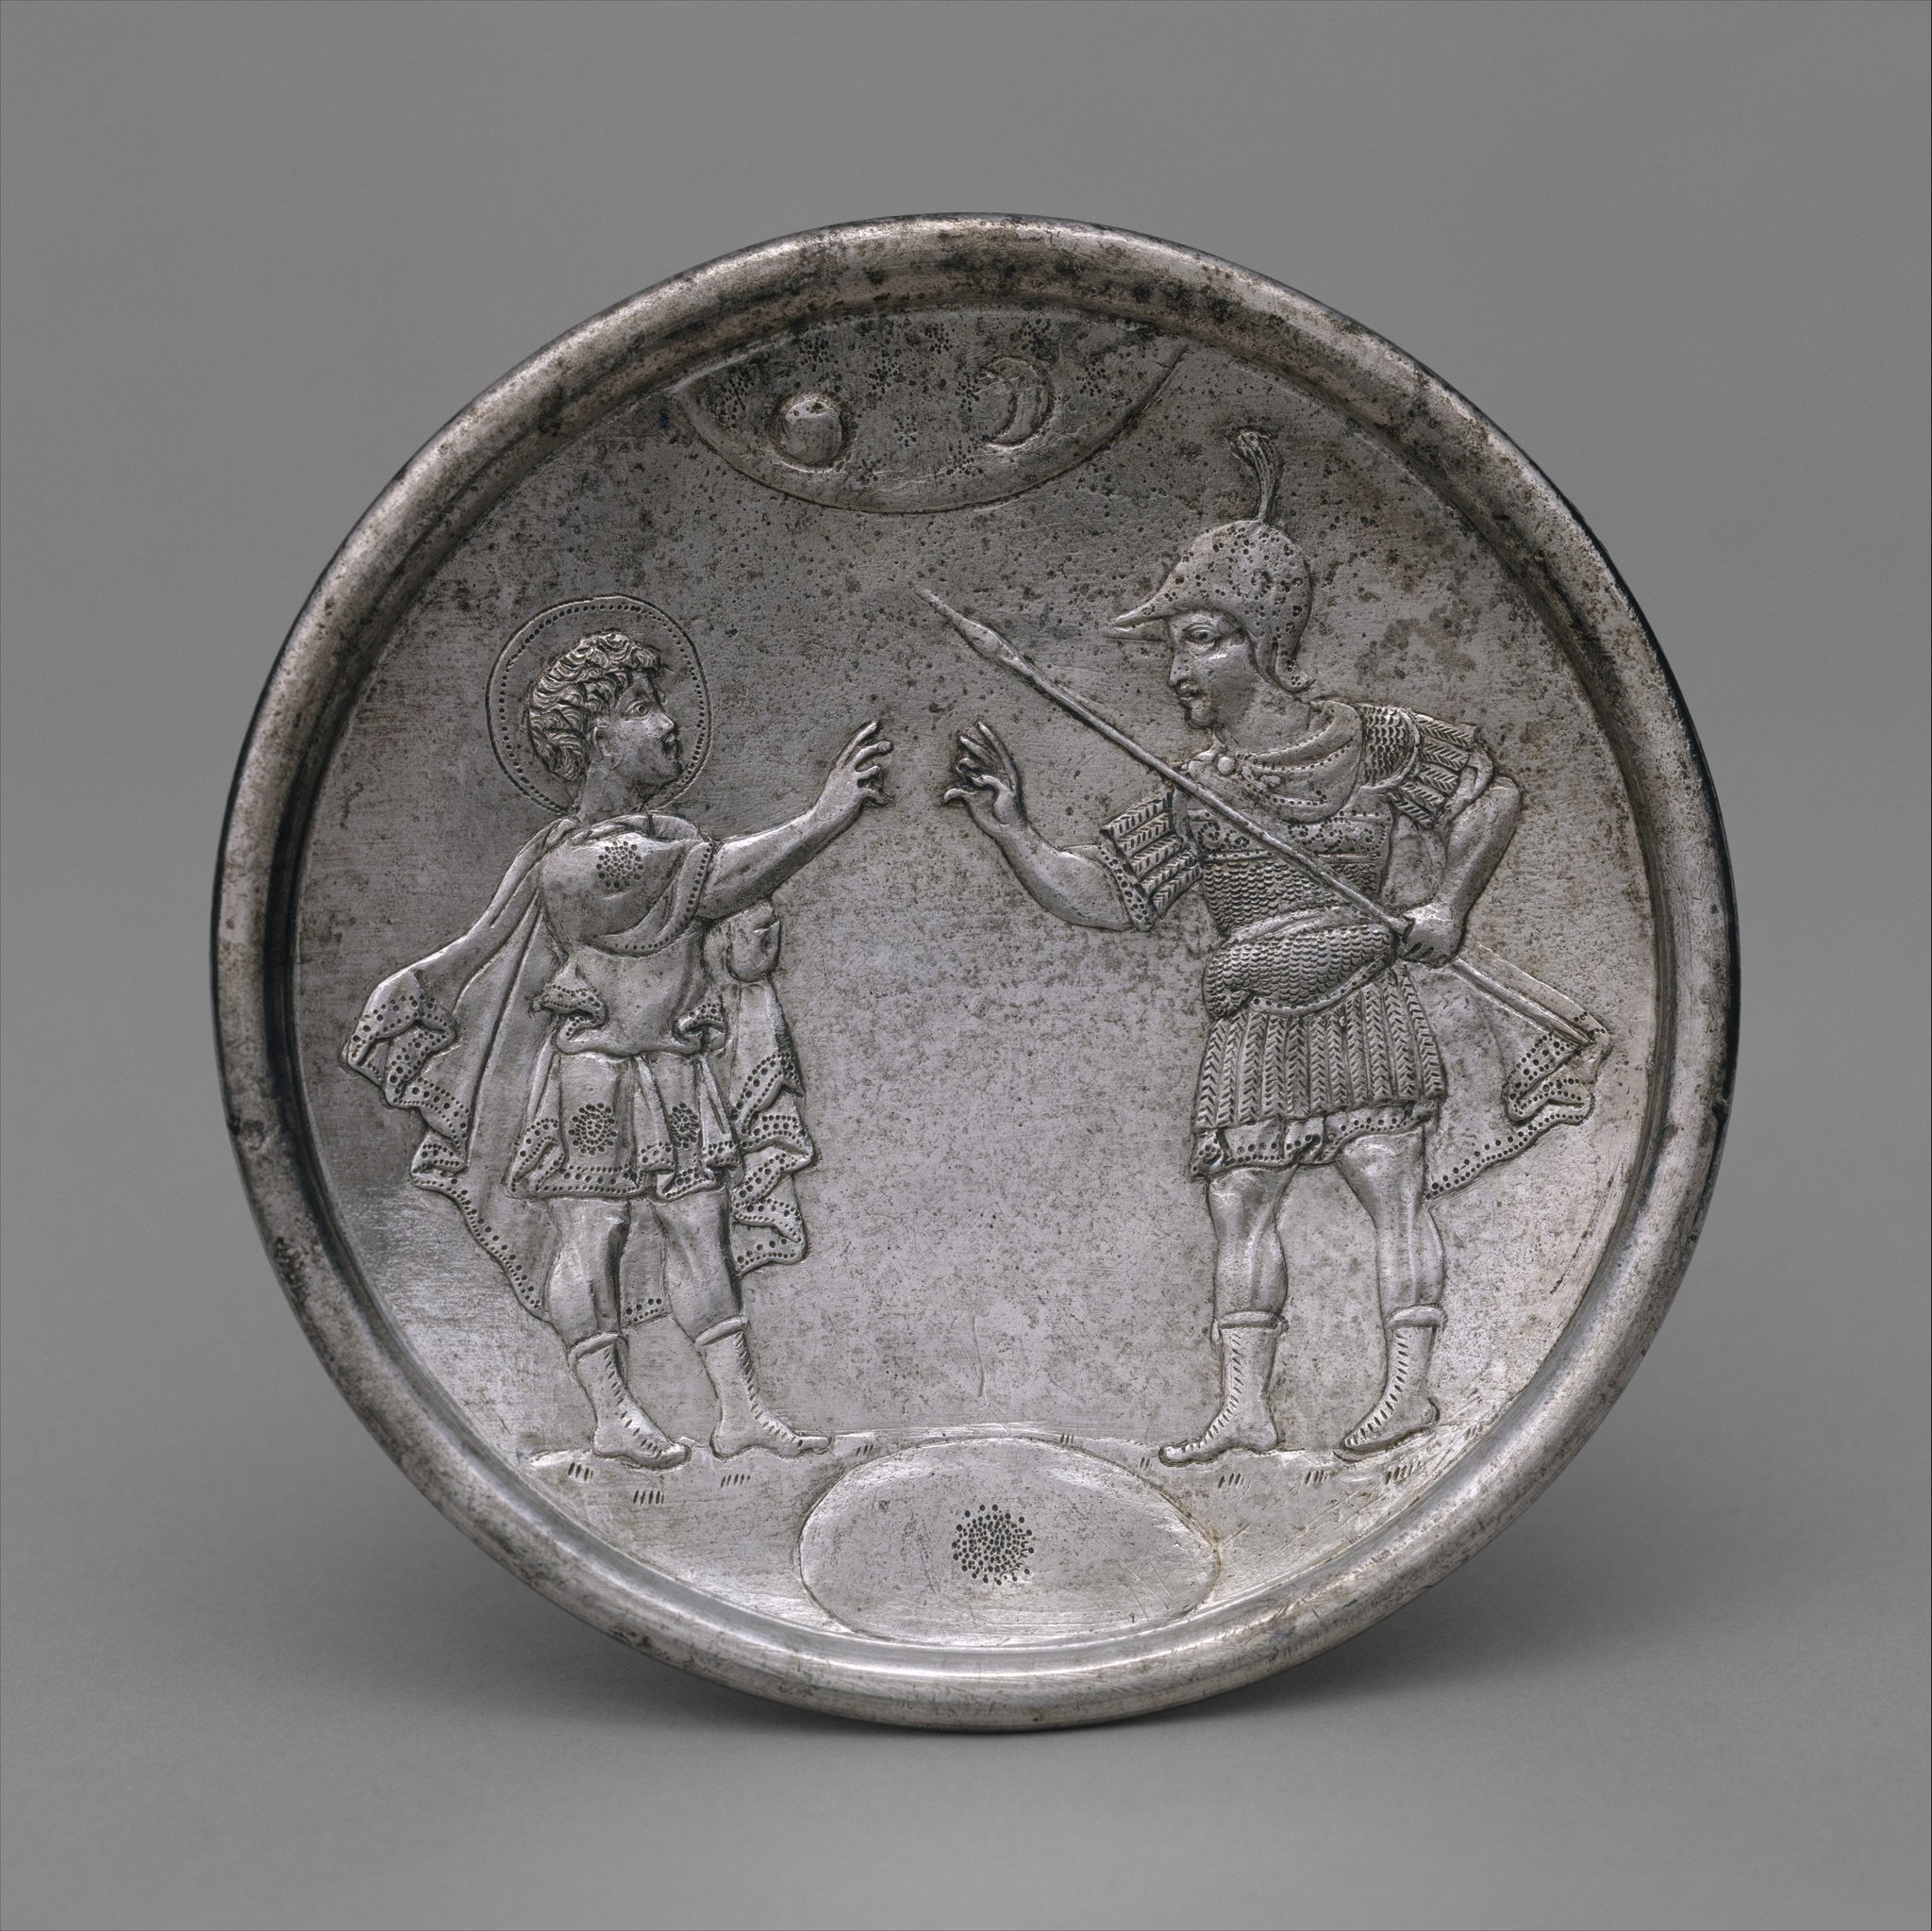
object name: plate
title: Plate with David's Confrontation with Eliab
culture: byzantine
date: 629-630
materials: silver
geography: constantinople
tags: spears,david,warriors